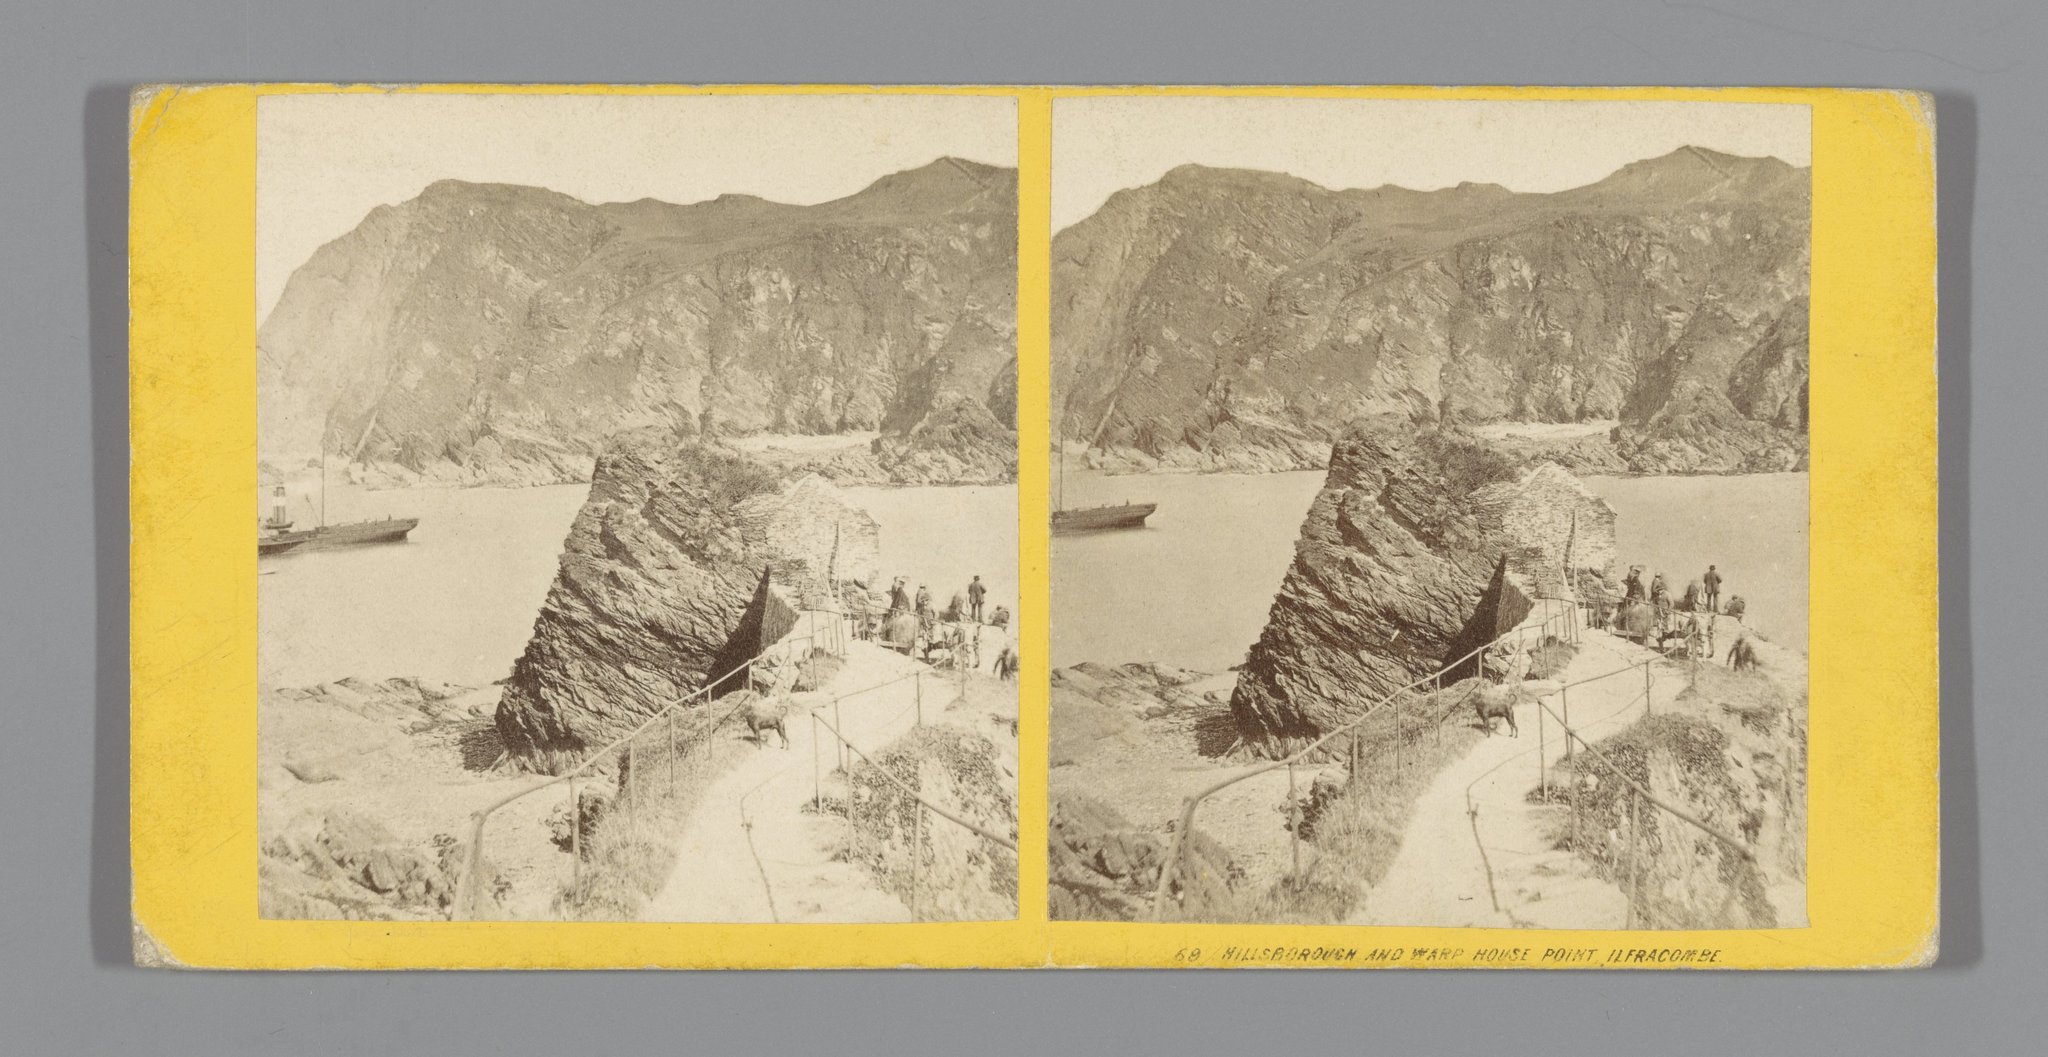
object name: stereograph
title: Hillsborough and Warp House Point, Ilfracombe.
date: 1850-1880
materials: cardboard, photographic support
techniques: albumen print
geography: exeter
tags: rocky coast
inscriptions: name: ‘William Spreat, Publisher, 229, High Street, Exeter’, number: ‘68.’